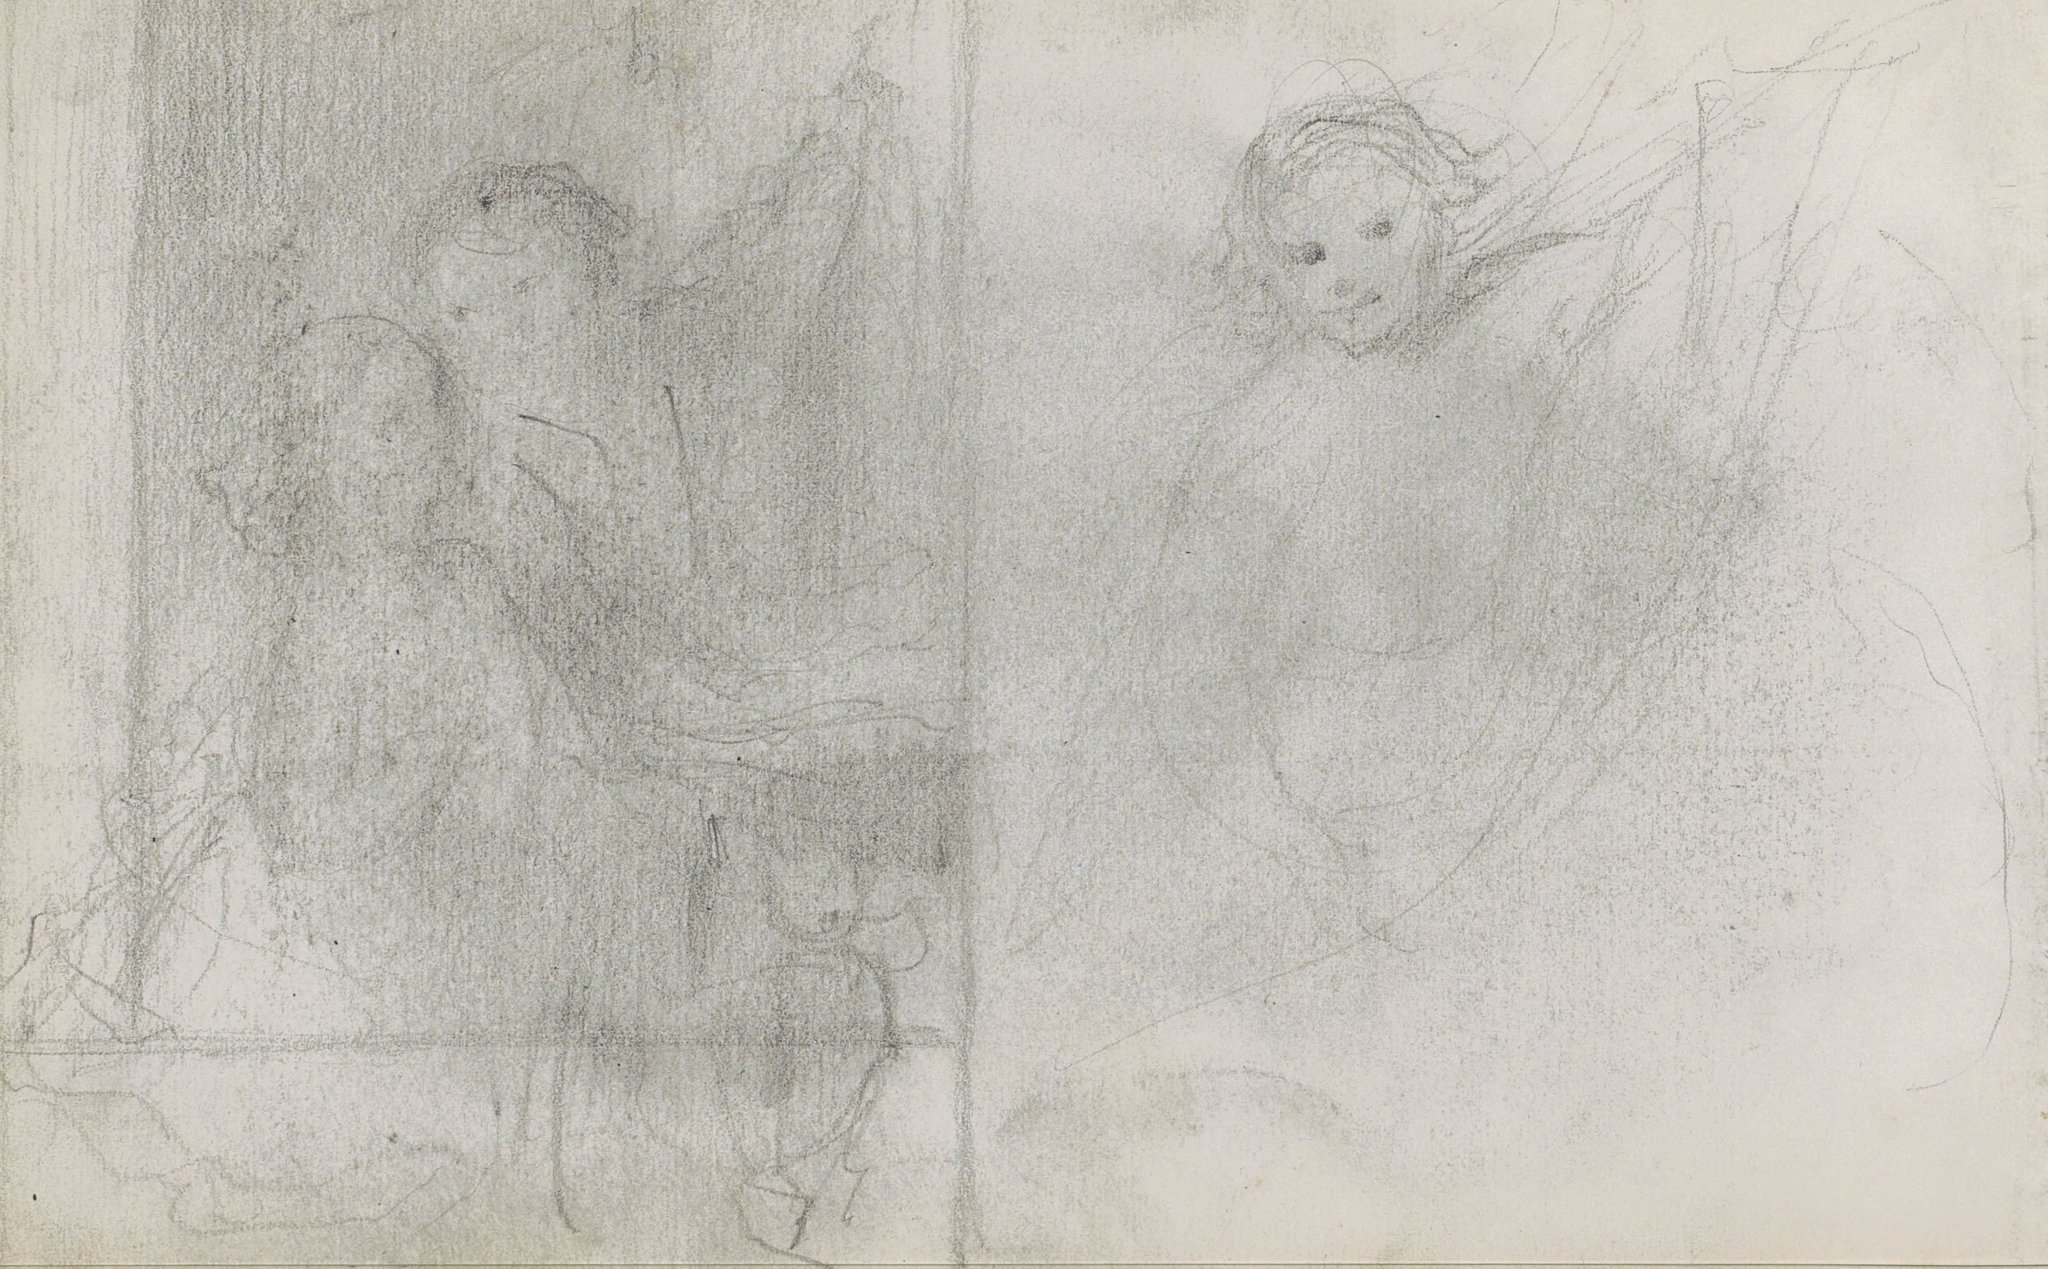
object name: sketchbook leaf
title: Studieblad met meisjes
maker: bastiaan de poorter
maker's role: painter, print maker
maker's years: 1813-1880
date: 1858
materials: paper, pencil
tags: girl (child between toddler and youth)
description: Onder andere een studie van twee meisjes in een nis. Blad 13 verso uit een gecombineerd album amicorum en schetsboek met in totaal 39 bladen.